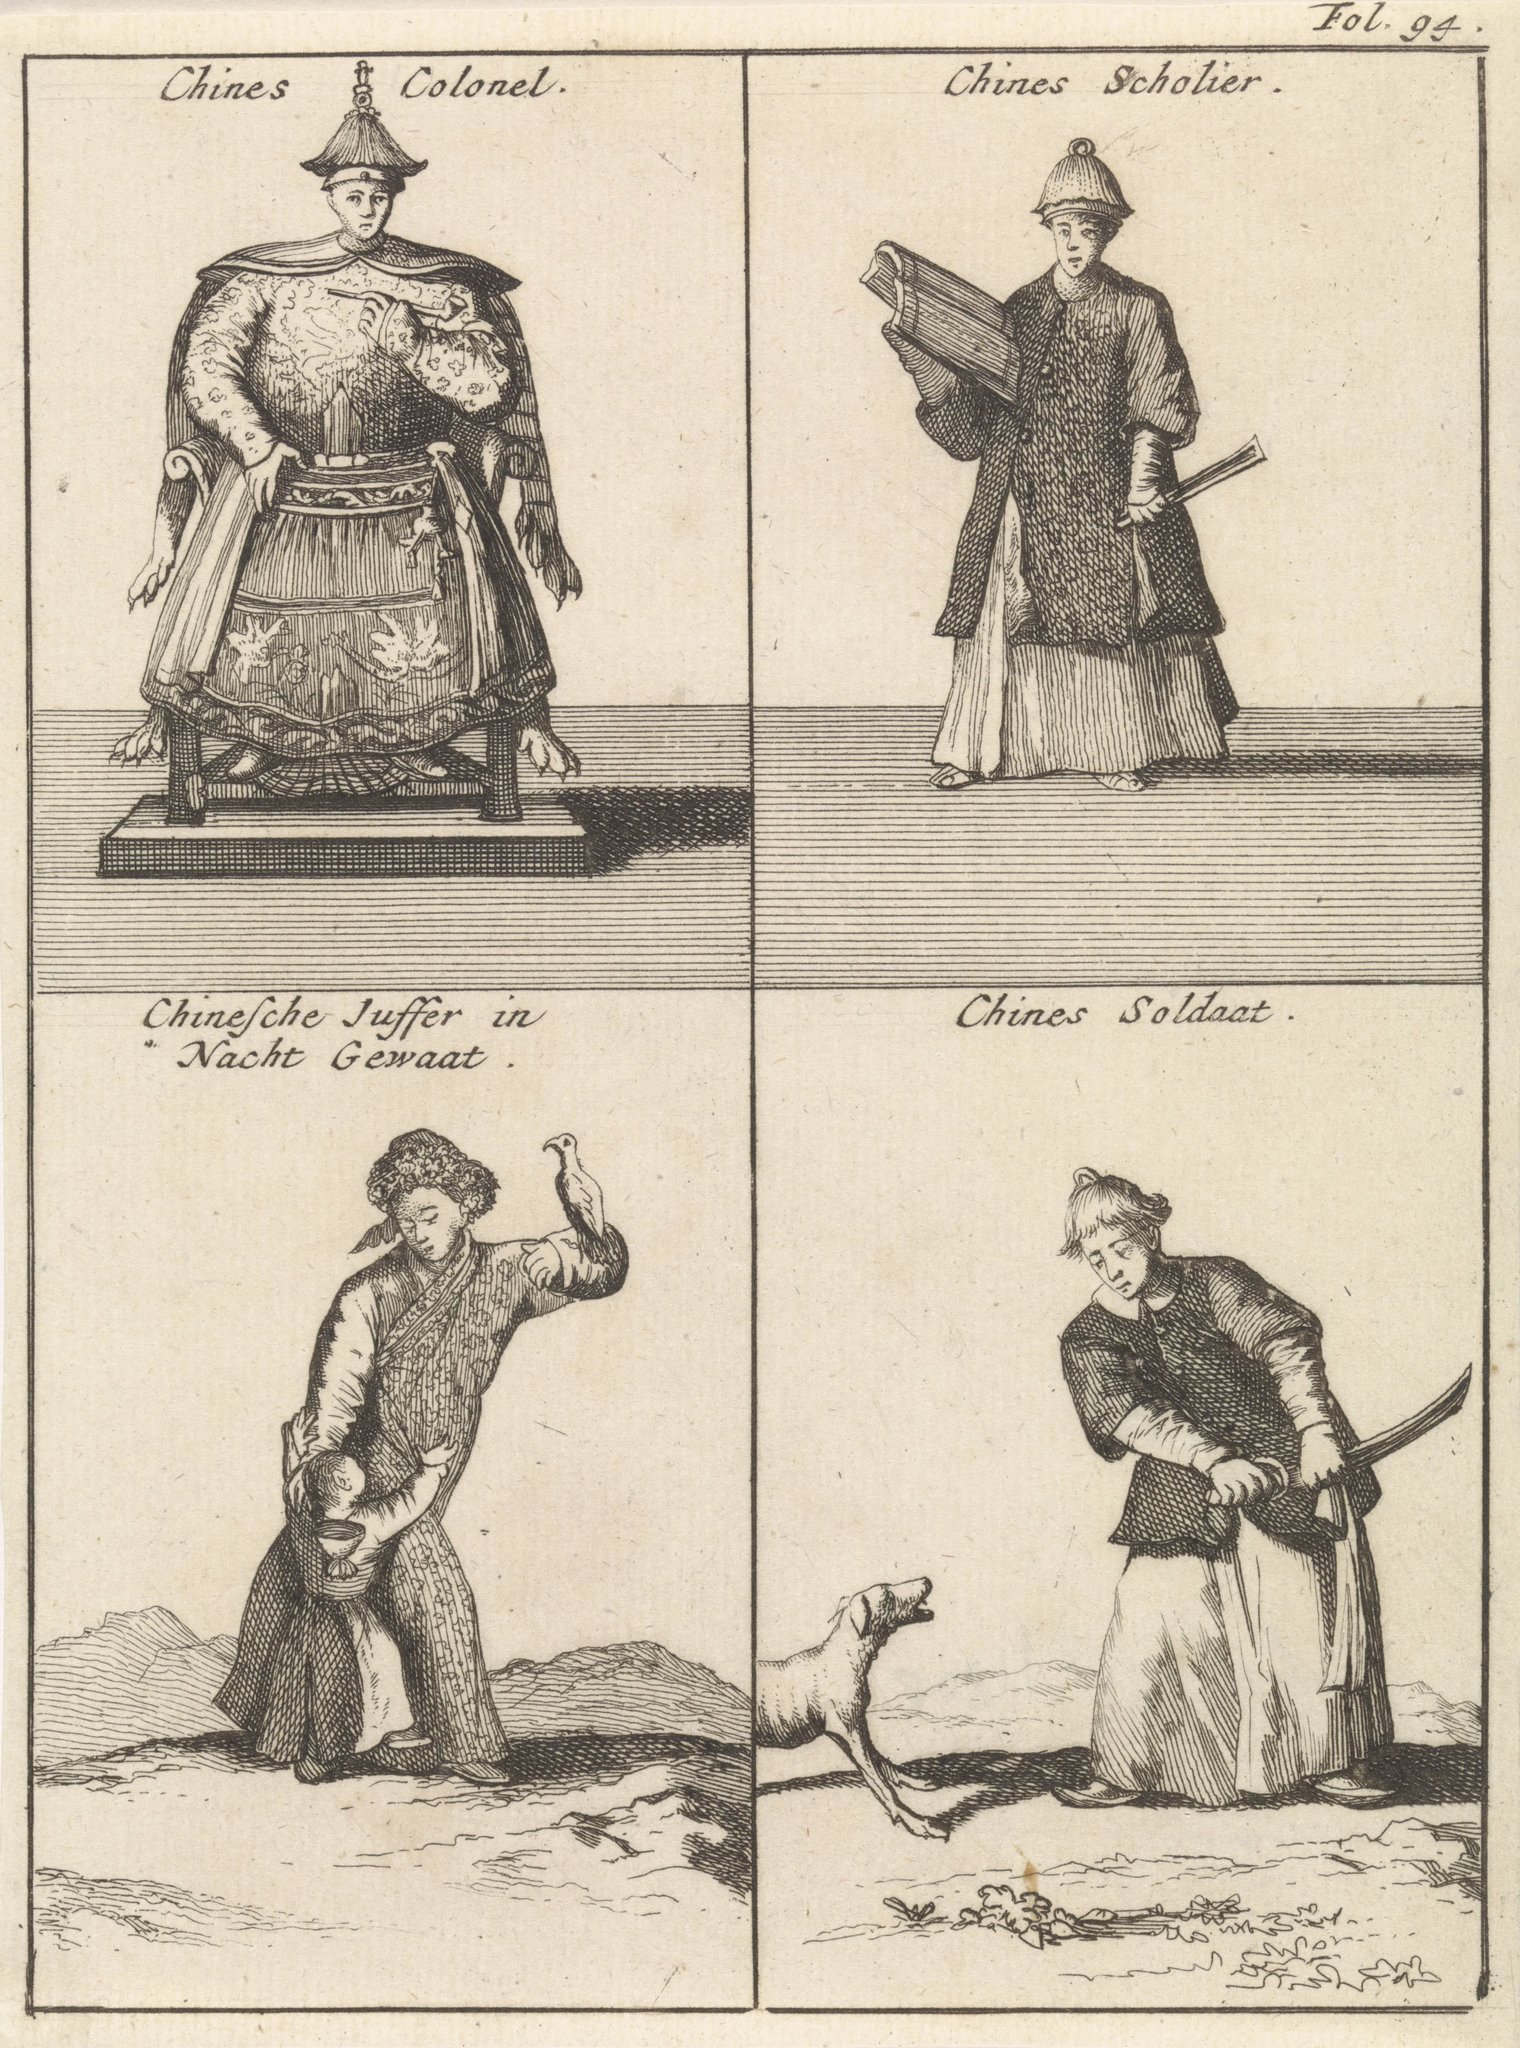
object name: print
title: Chinese kolonel / Chinese scholier / Chinese vrouw in slaapkleding / Chinese soldaat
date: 1698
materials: paper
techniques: etching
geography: amsterdam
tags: chinese (+ costume)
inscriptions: collector's mark: Lugt 2228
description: Illustratie uit: Le Comte, Louis. Beschryvinge van het machtige keyserryk China, 2 delen. Den Haag: Engelbrecht Boucquet, 1698.